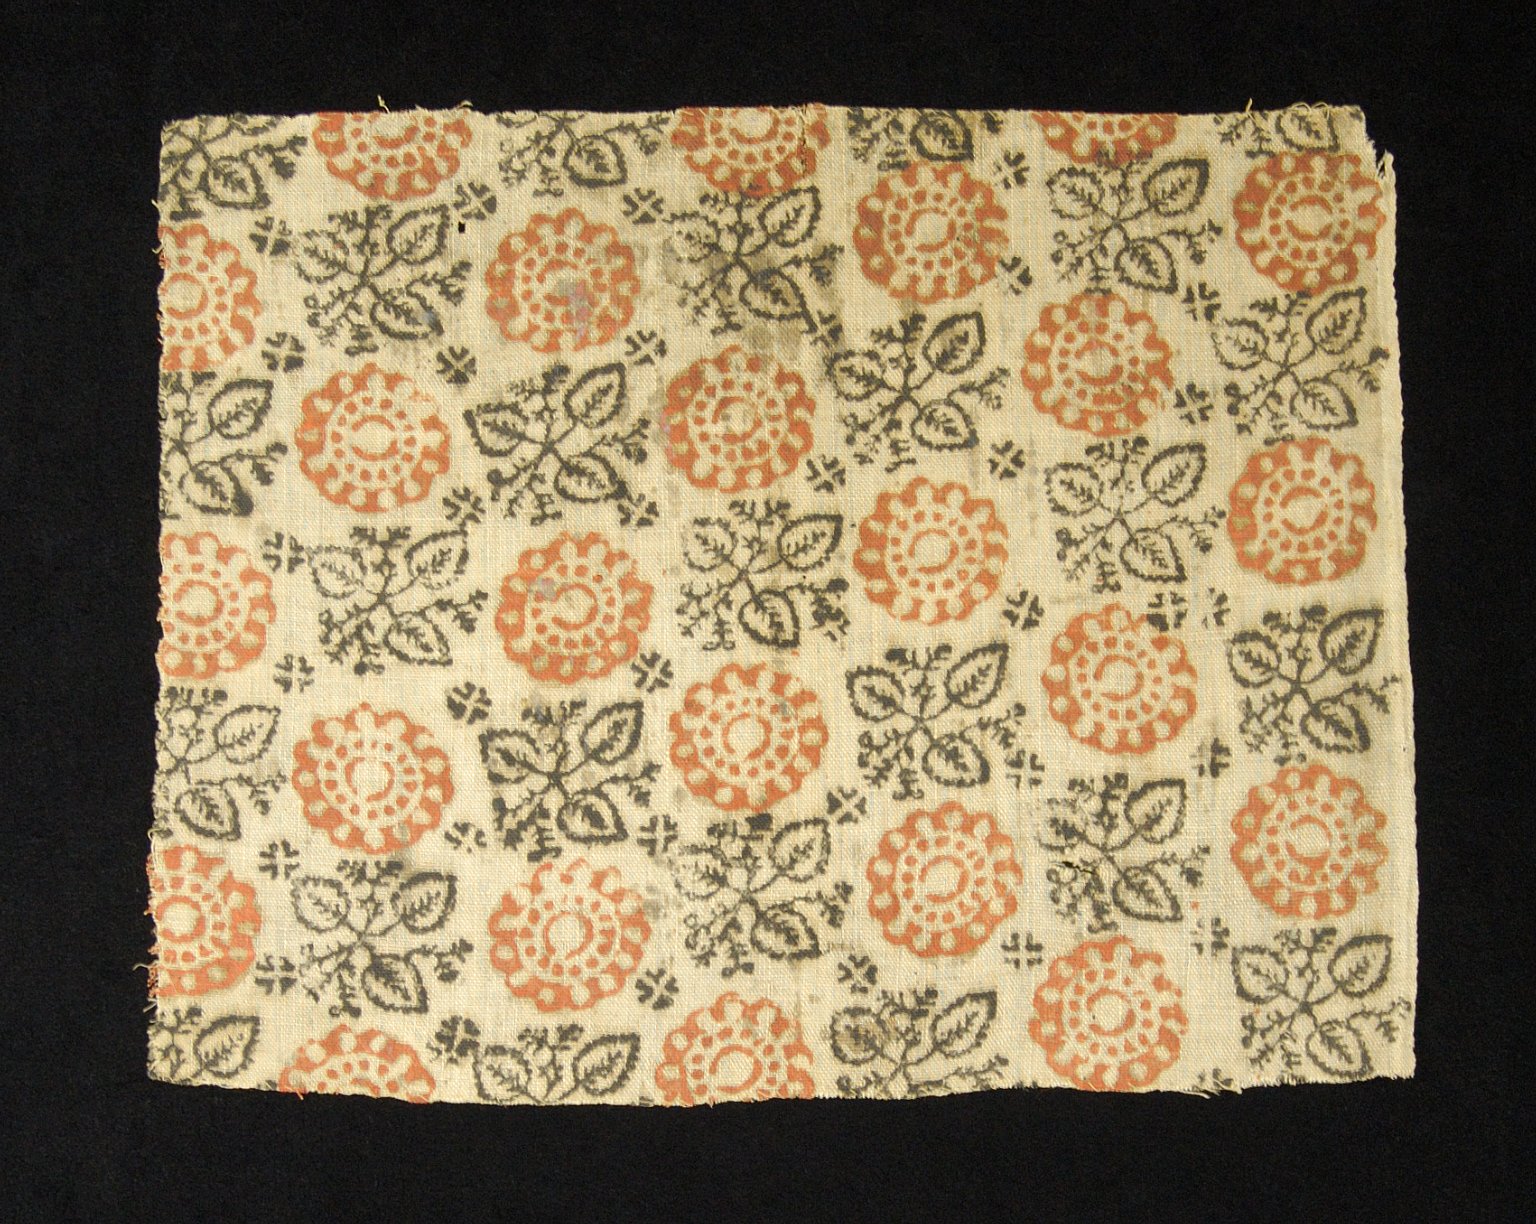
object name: fragment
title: Textile fragment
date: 1700-1899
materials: linen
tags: flowers